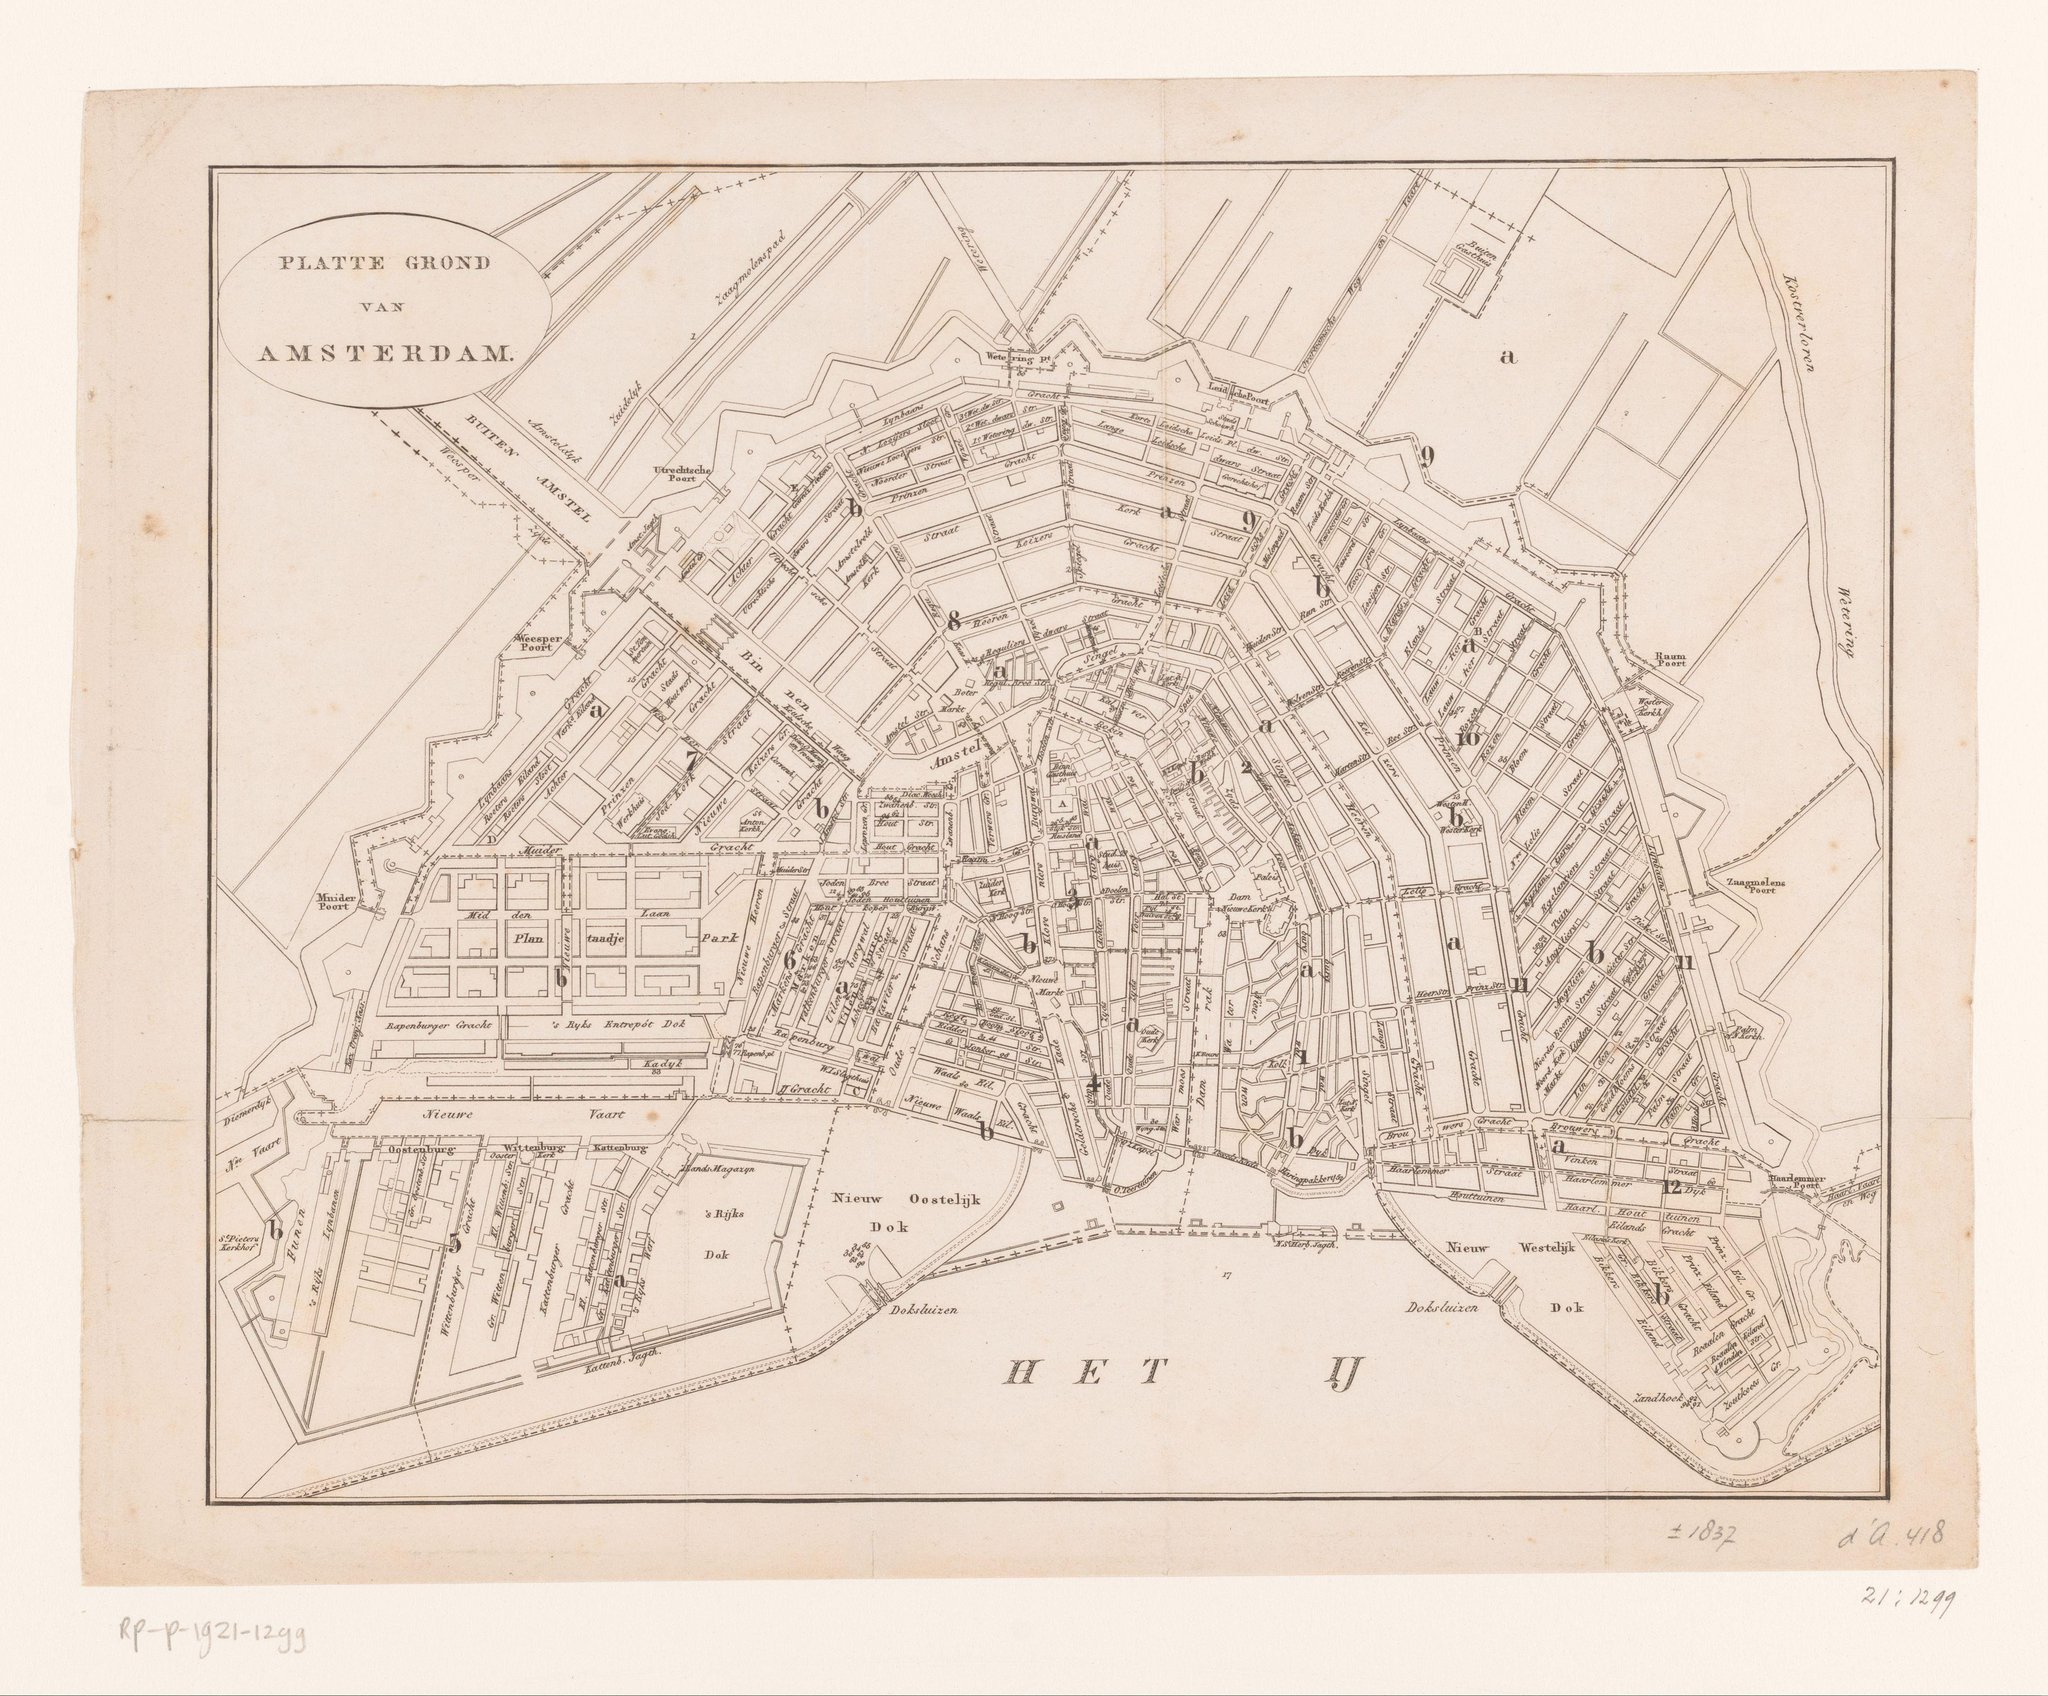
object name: area plan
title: Platte Grond van Amsterdam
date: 1833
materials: paper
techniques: lithograph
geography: amsterdam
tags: maps of cities, amsterdam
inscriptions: collector's mark: Lugt 2233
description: Prent uit: Arntzenius, D.J.A. Berigten omtrent den Aziatischen braakloop te Amsterdam in het jaar 1832. Amsterdam: L. van der Vinne, 1833.